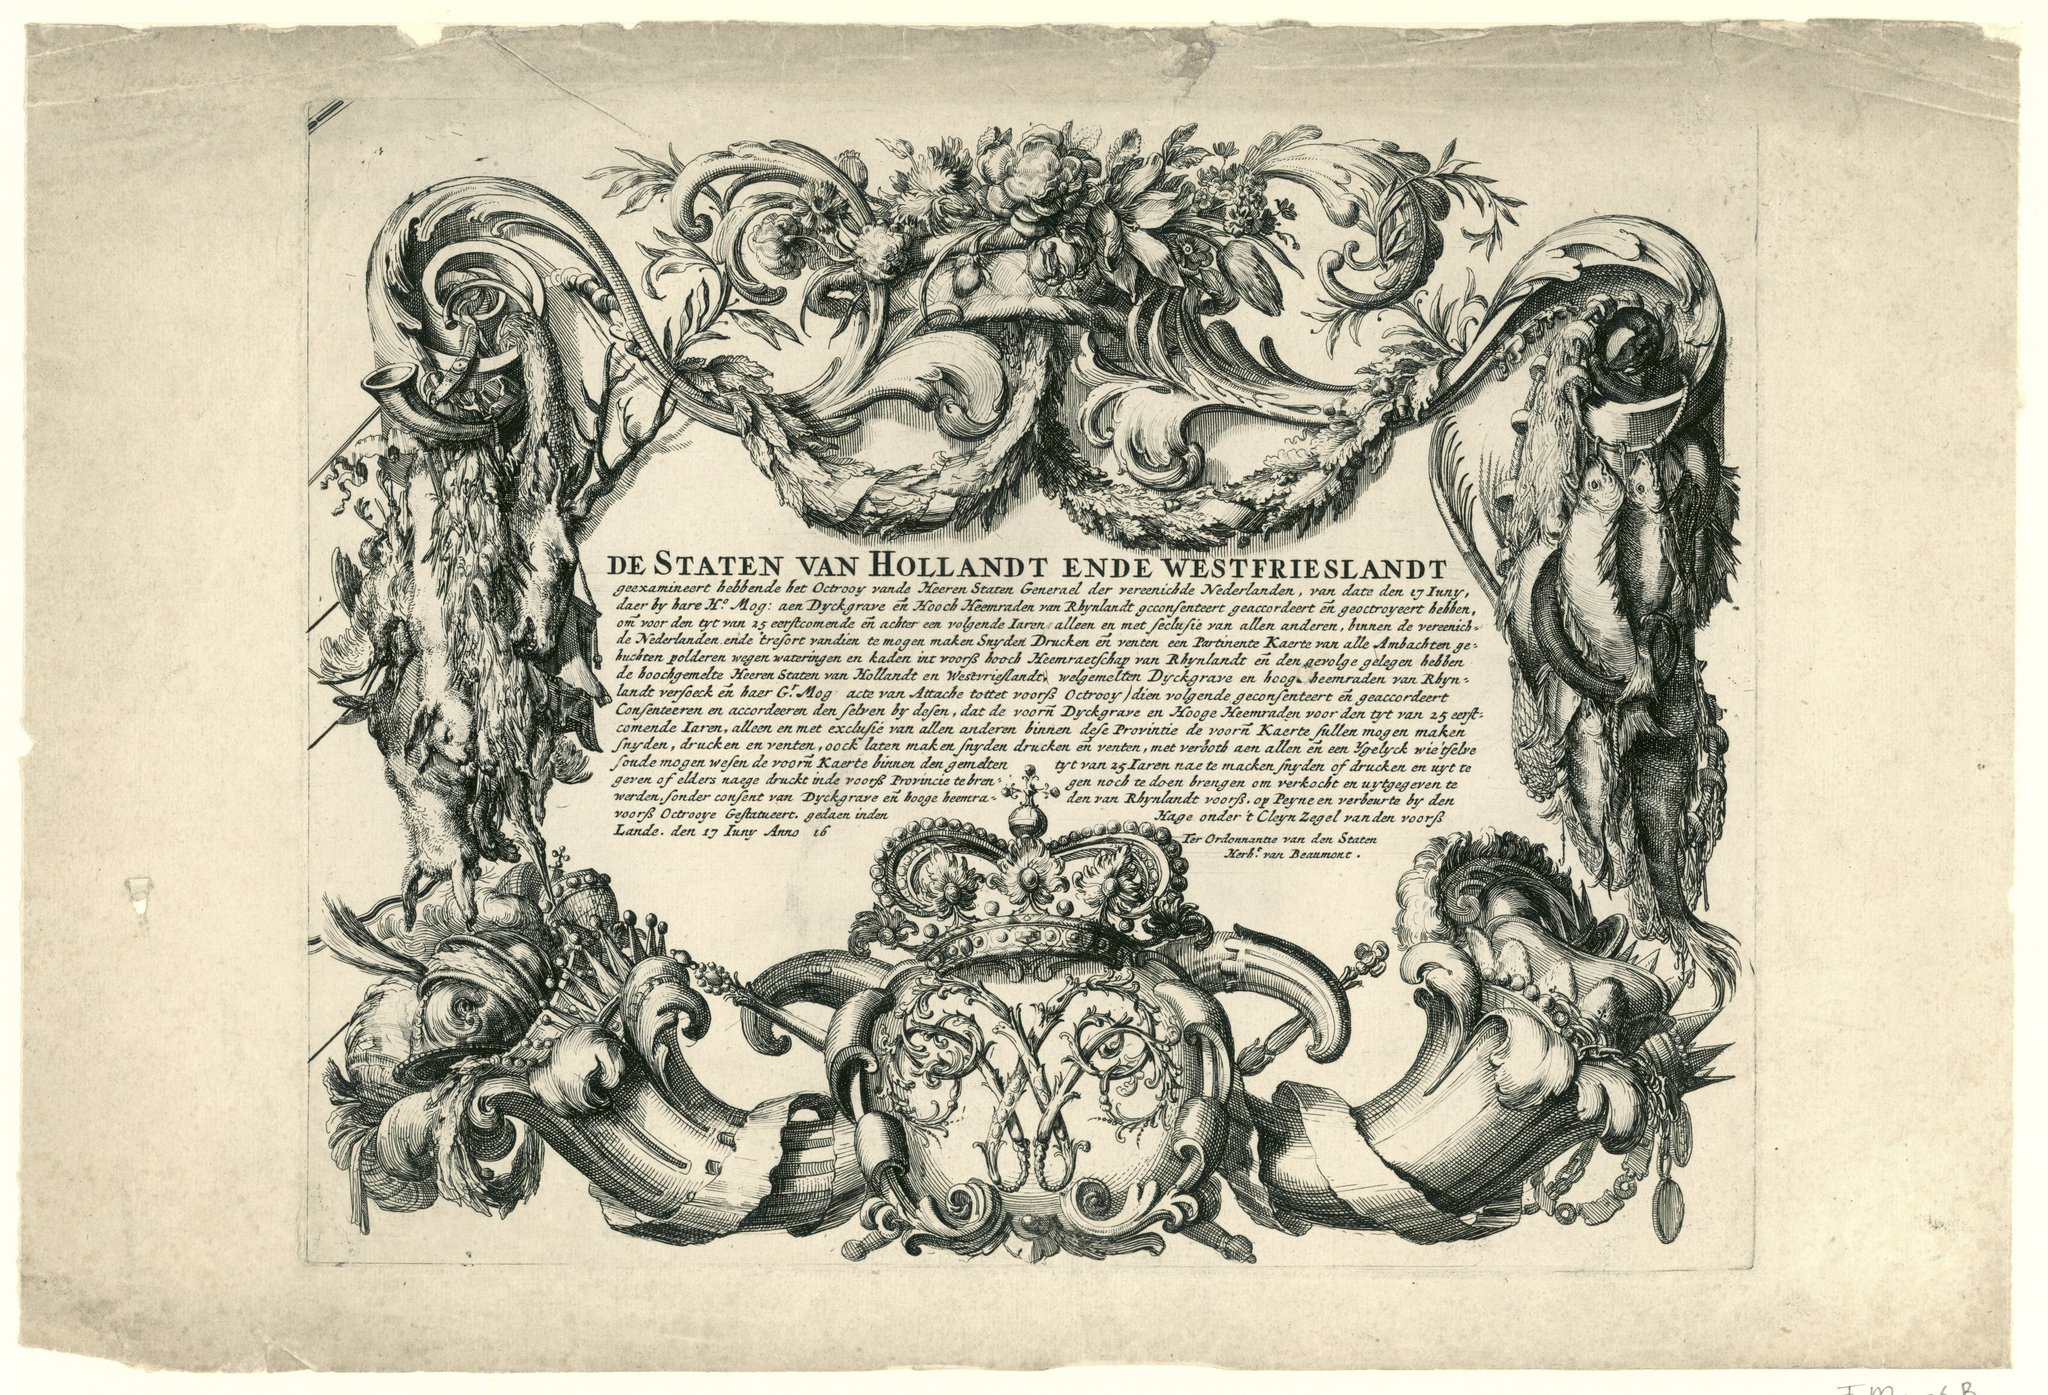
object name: print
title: Octrooi verleend door de Staten van Holland en West-Friesland voor een kaart van het Hoogheemraadschap van Rijnland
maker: romeyn de hooghe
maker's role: draughtsman, goldsmith, painter, print maker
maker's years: 1645-1708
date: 1687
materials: paper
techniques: engraving, etching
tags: ornaments ~ art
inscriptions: collector's mark: Lugt 2760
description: Ornamentale cartouche met een tekst waarin door de Staten van Holland en West-Friesland, in overeenstemming met het octrooi van de Staten-Generaal (RP-P-AO-10-7-1), aan de dijkgraaf en hoogheemraden van Rijnland een octrooi van 25 jaar wordt verleend voor het vervaardigen en uitgeven van een kaart van het Hoogheemraadschap van Rijnland. Deze cartouche werd voor de tweede druk van de kaart (1687, de eerste druk verscheen in 1647) speciaal ontworpen door Romeyn de Hooghe.